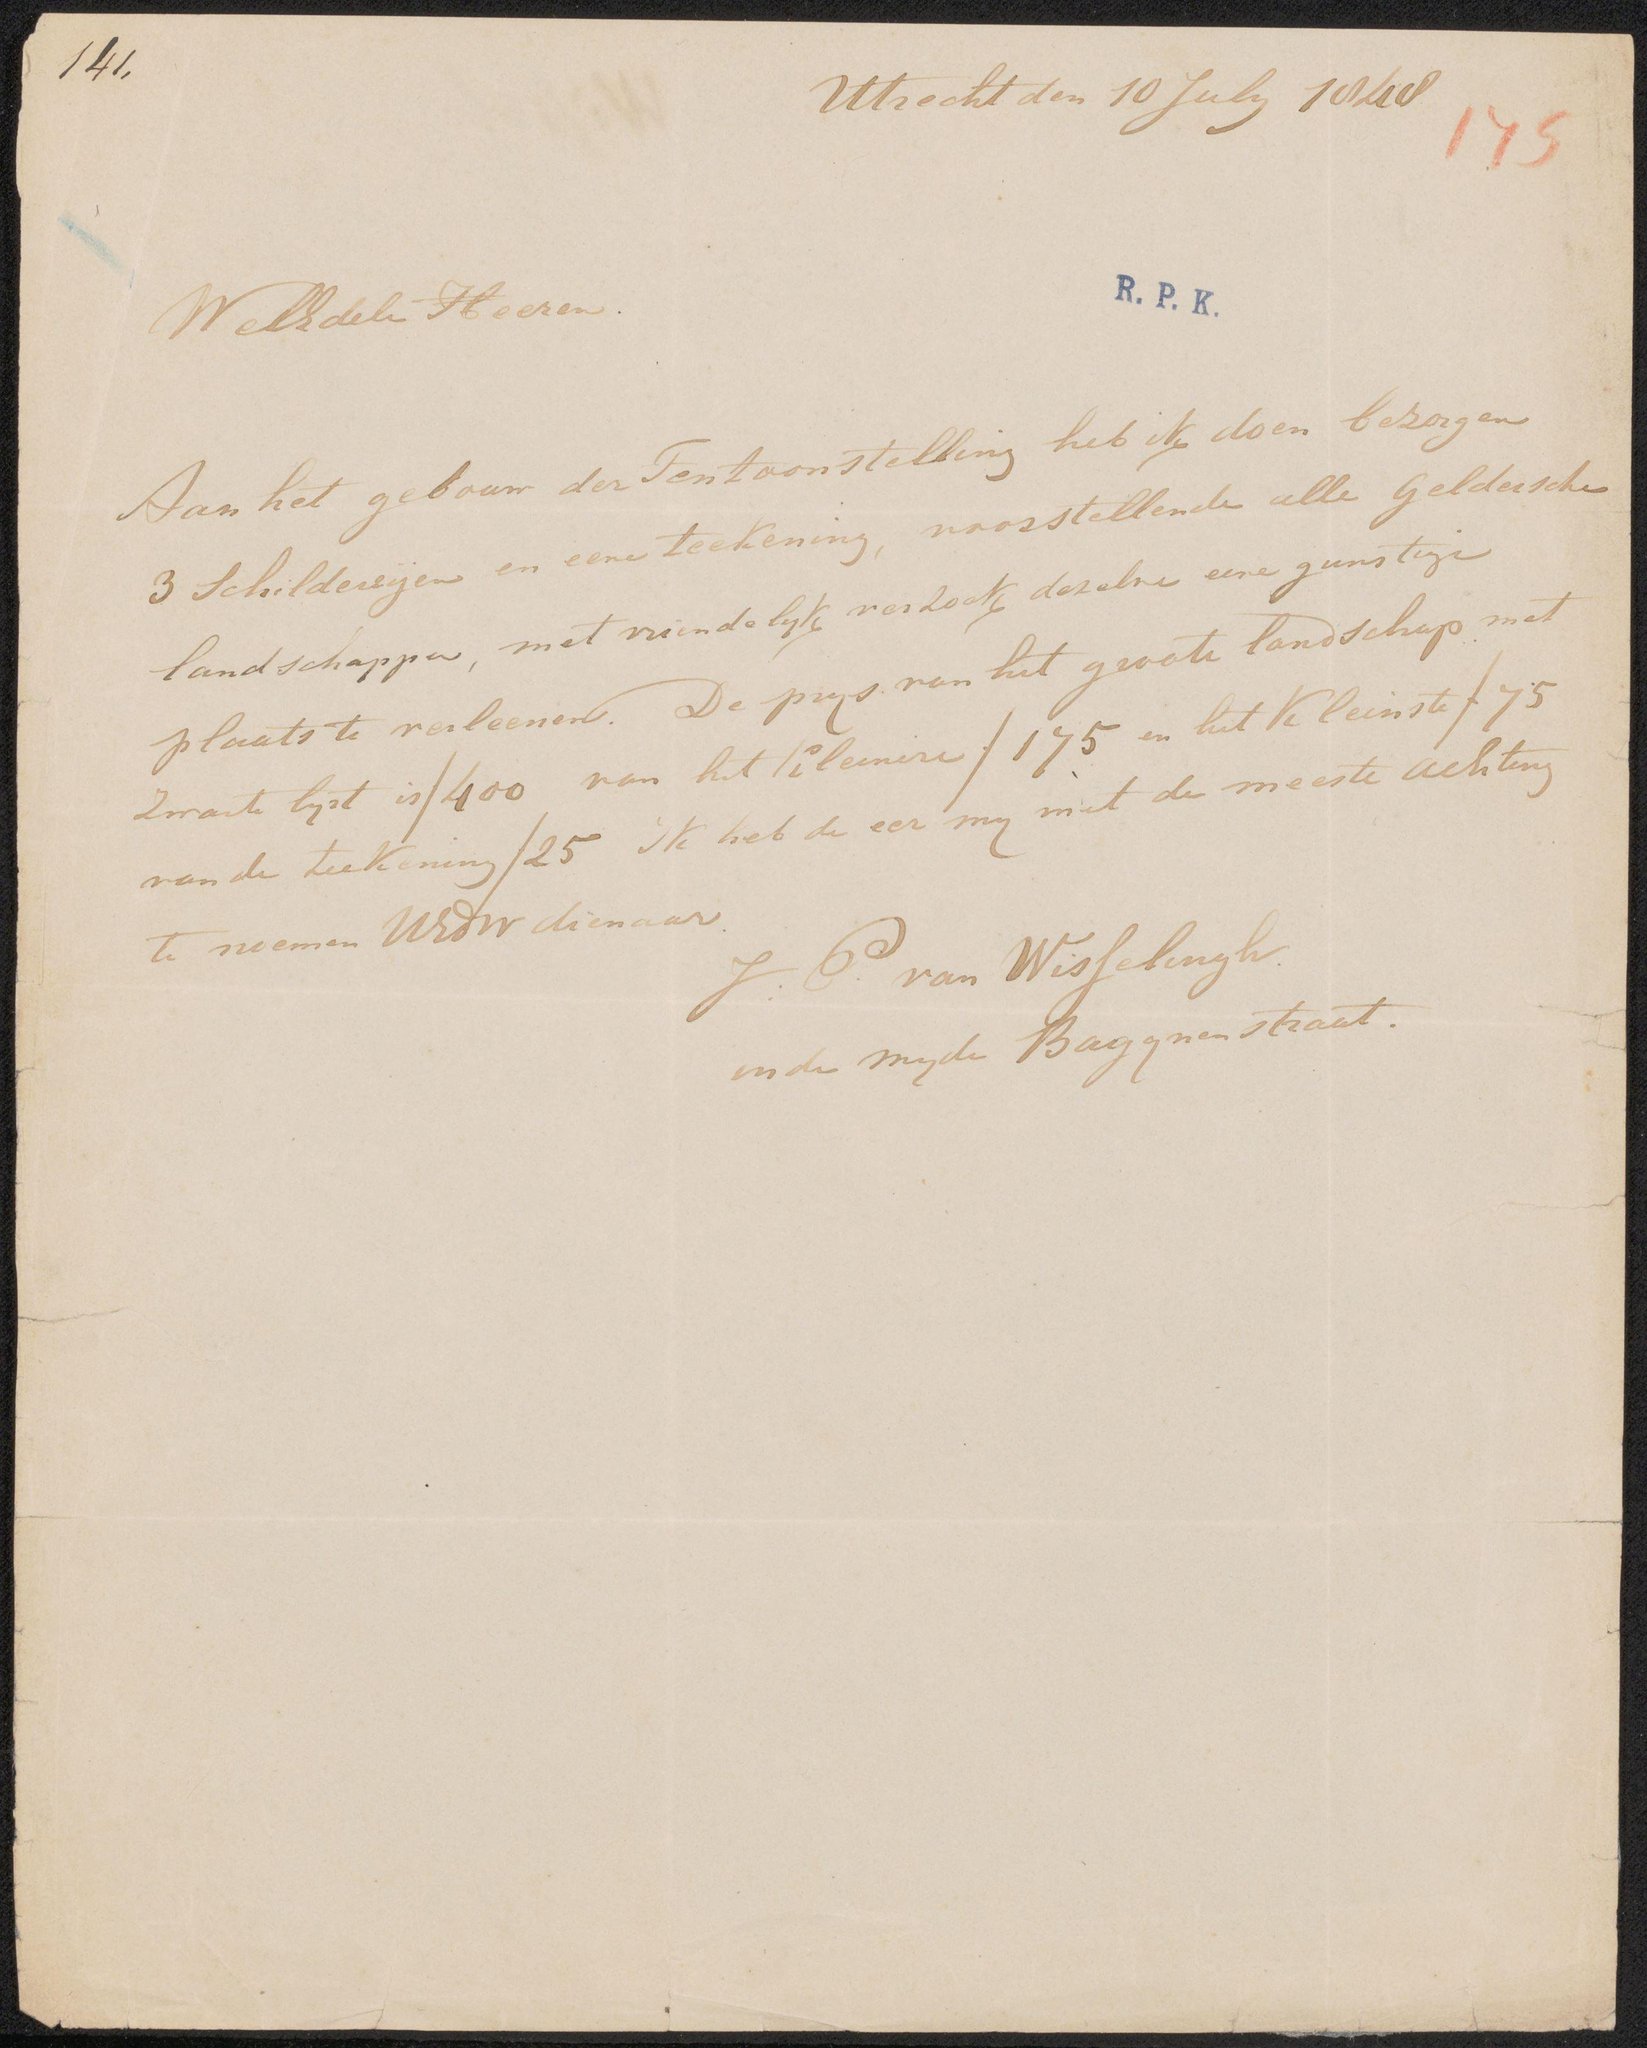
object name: letter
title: Brief aan de Commissie van de Tentoonstelling van Levende Meesters in Utrecht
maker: johannes pieter van wisselingh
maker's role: draughtsman, painter, print maker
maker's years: 1812-1899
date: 1848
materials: ink, paper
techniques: pen, writing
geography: utrecht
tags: painting (including book-illumination, miniature-painting), exhibition ~ art, money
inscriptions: collector's mark: Lugt 2233